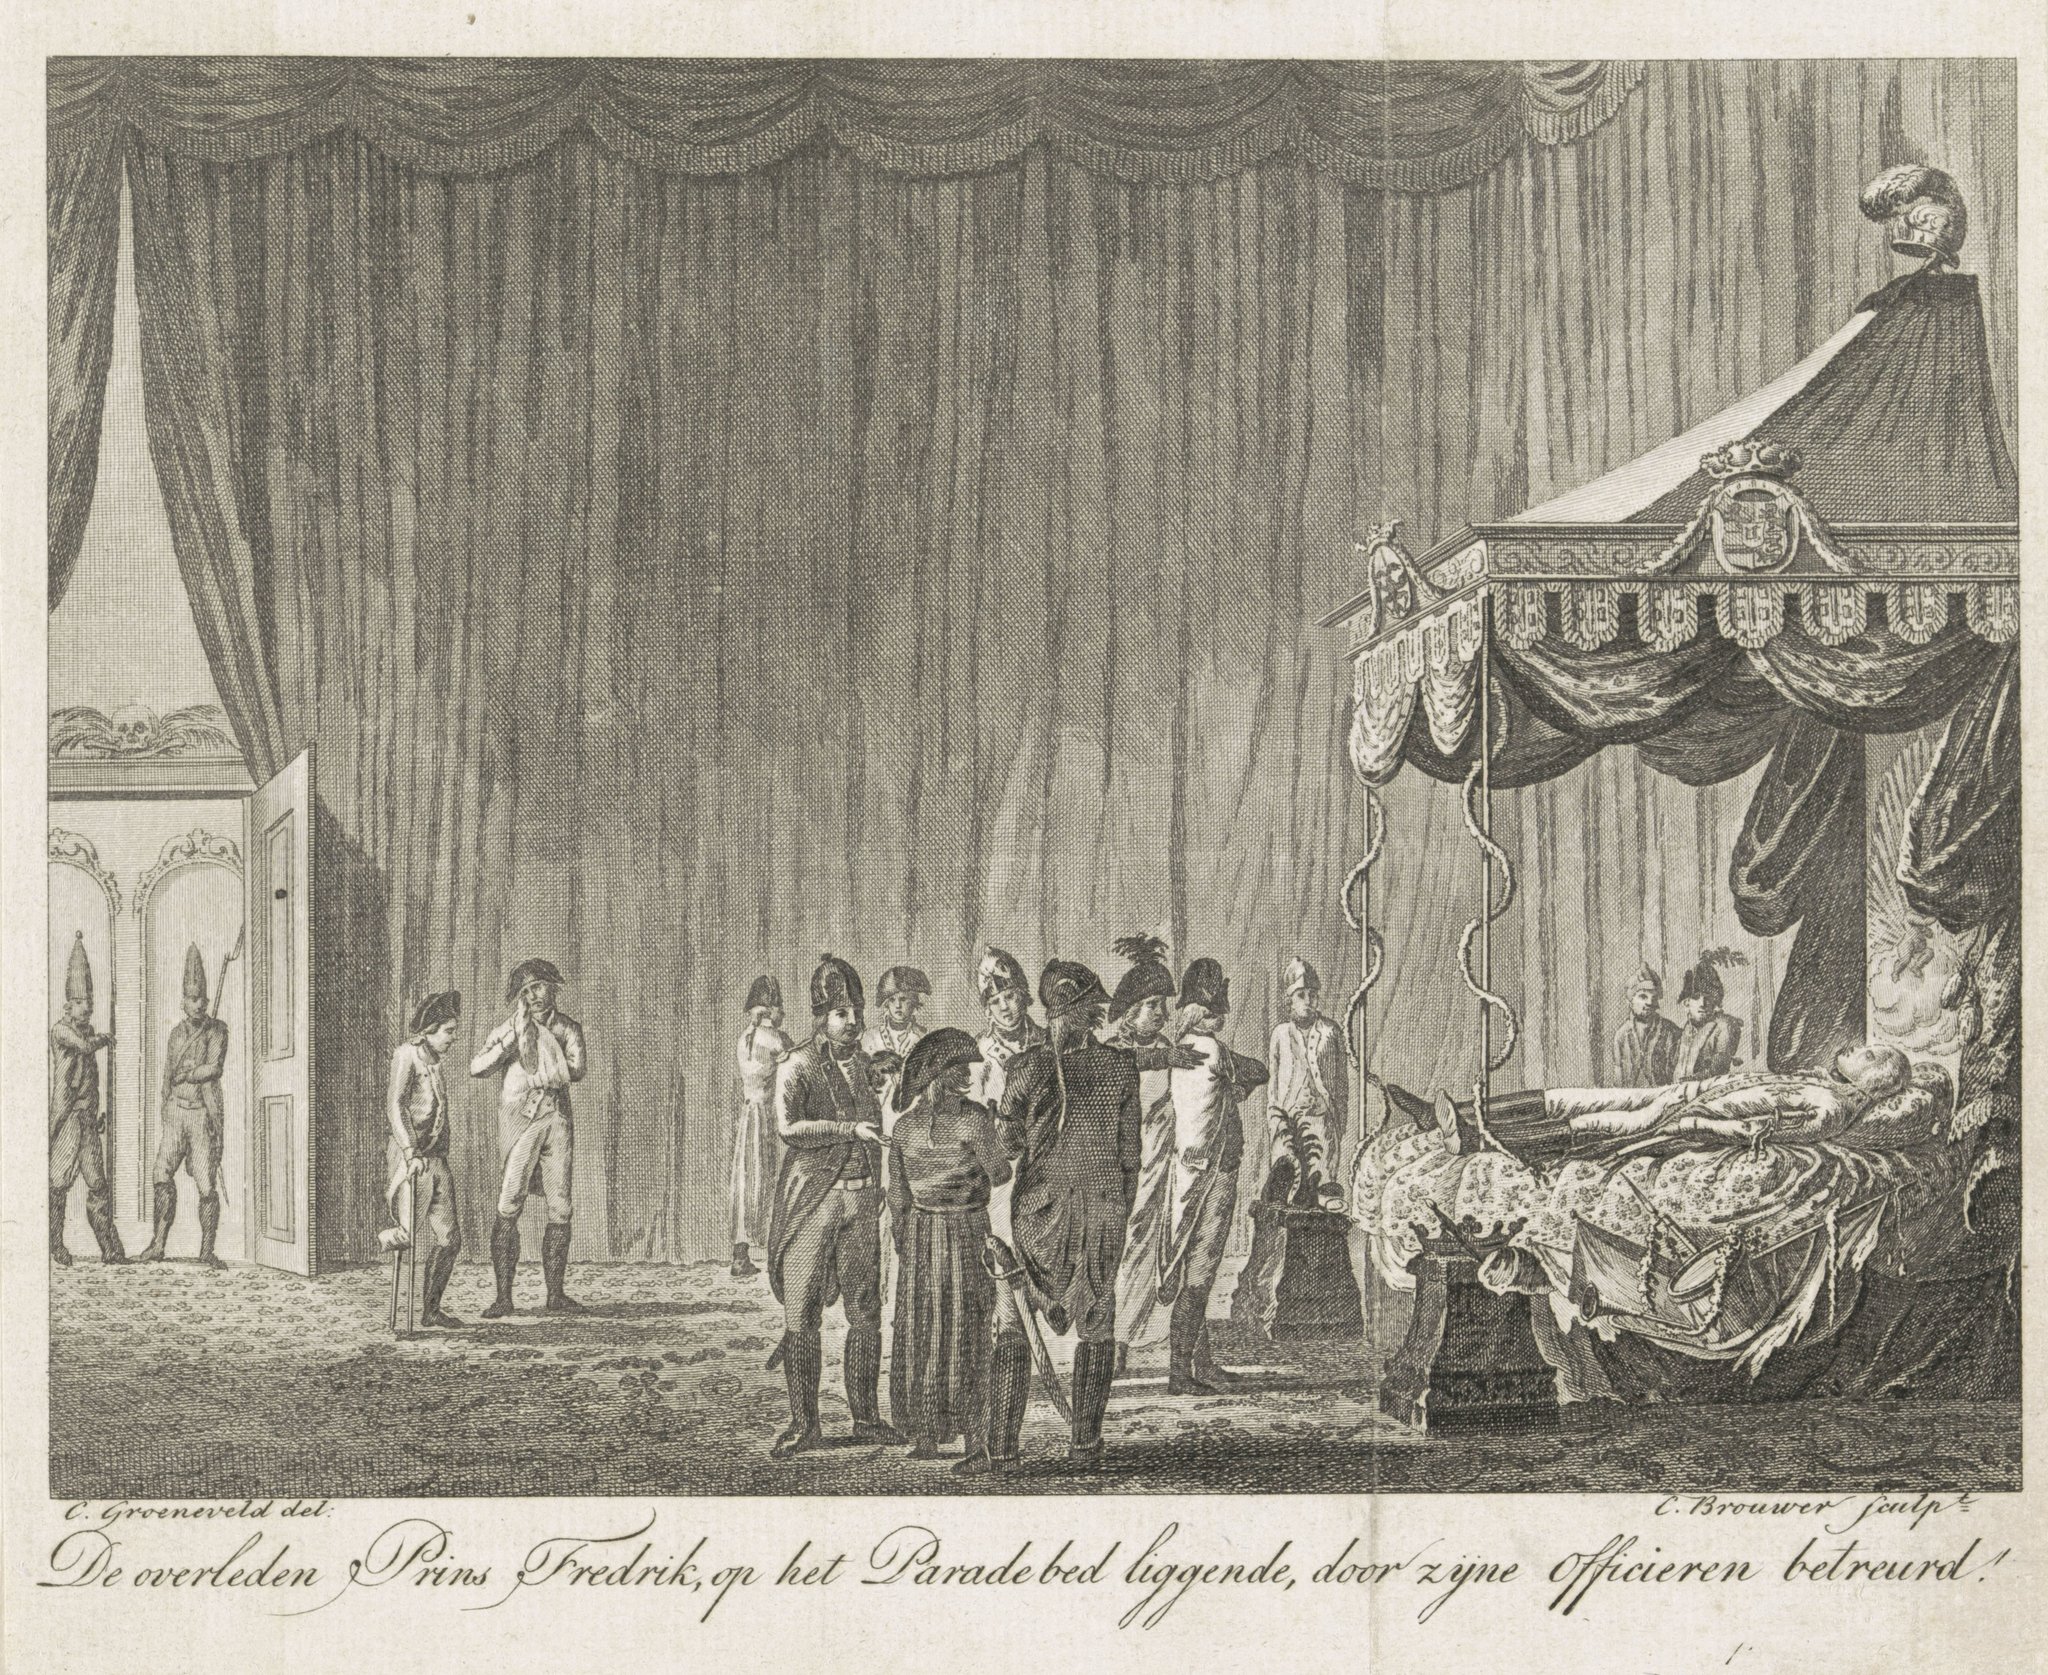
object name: print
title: Paradebed van prins Frederik, 1799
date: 1803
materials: paper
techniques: engraving, etching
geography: netherlands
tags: the hague, willem george frederik (prins van oranje-nassau), lying in state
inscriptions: collector's mark: Lugt 2228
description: Willem George Frederik, prins van Oranje-Nassau, liggend in uniform op zijn paradebed in Padua, 6 januari 1799. Om het bed treurende militairen.